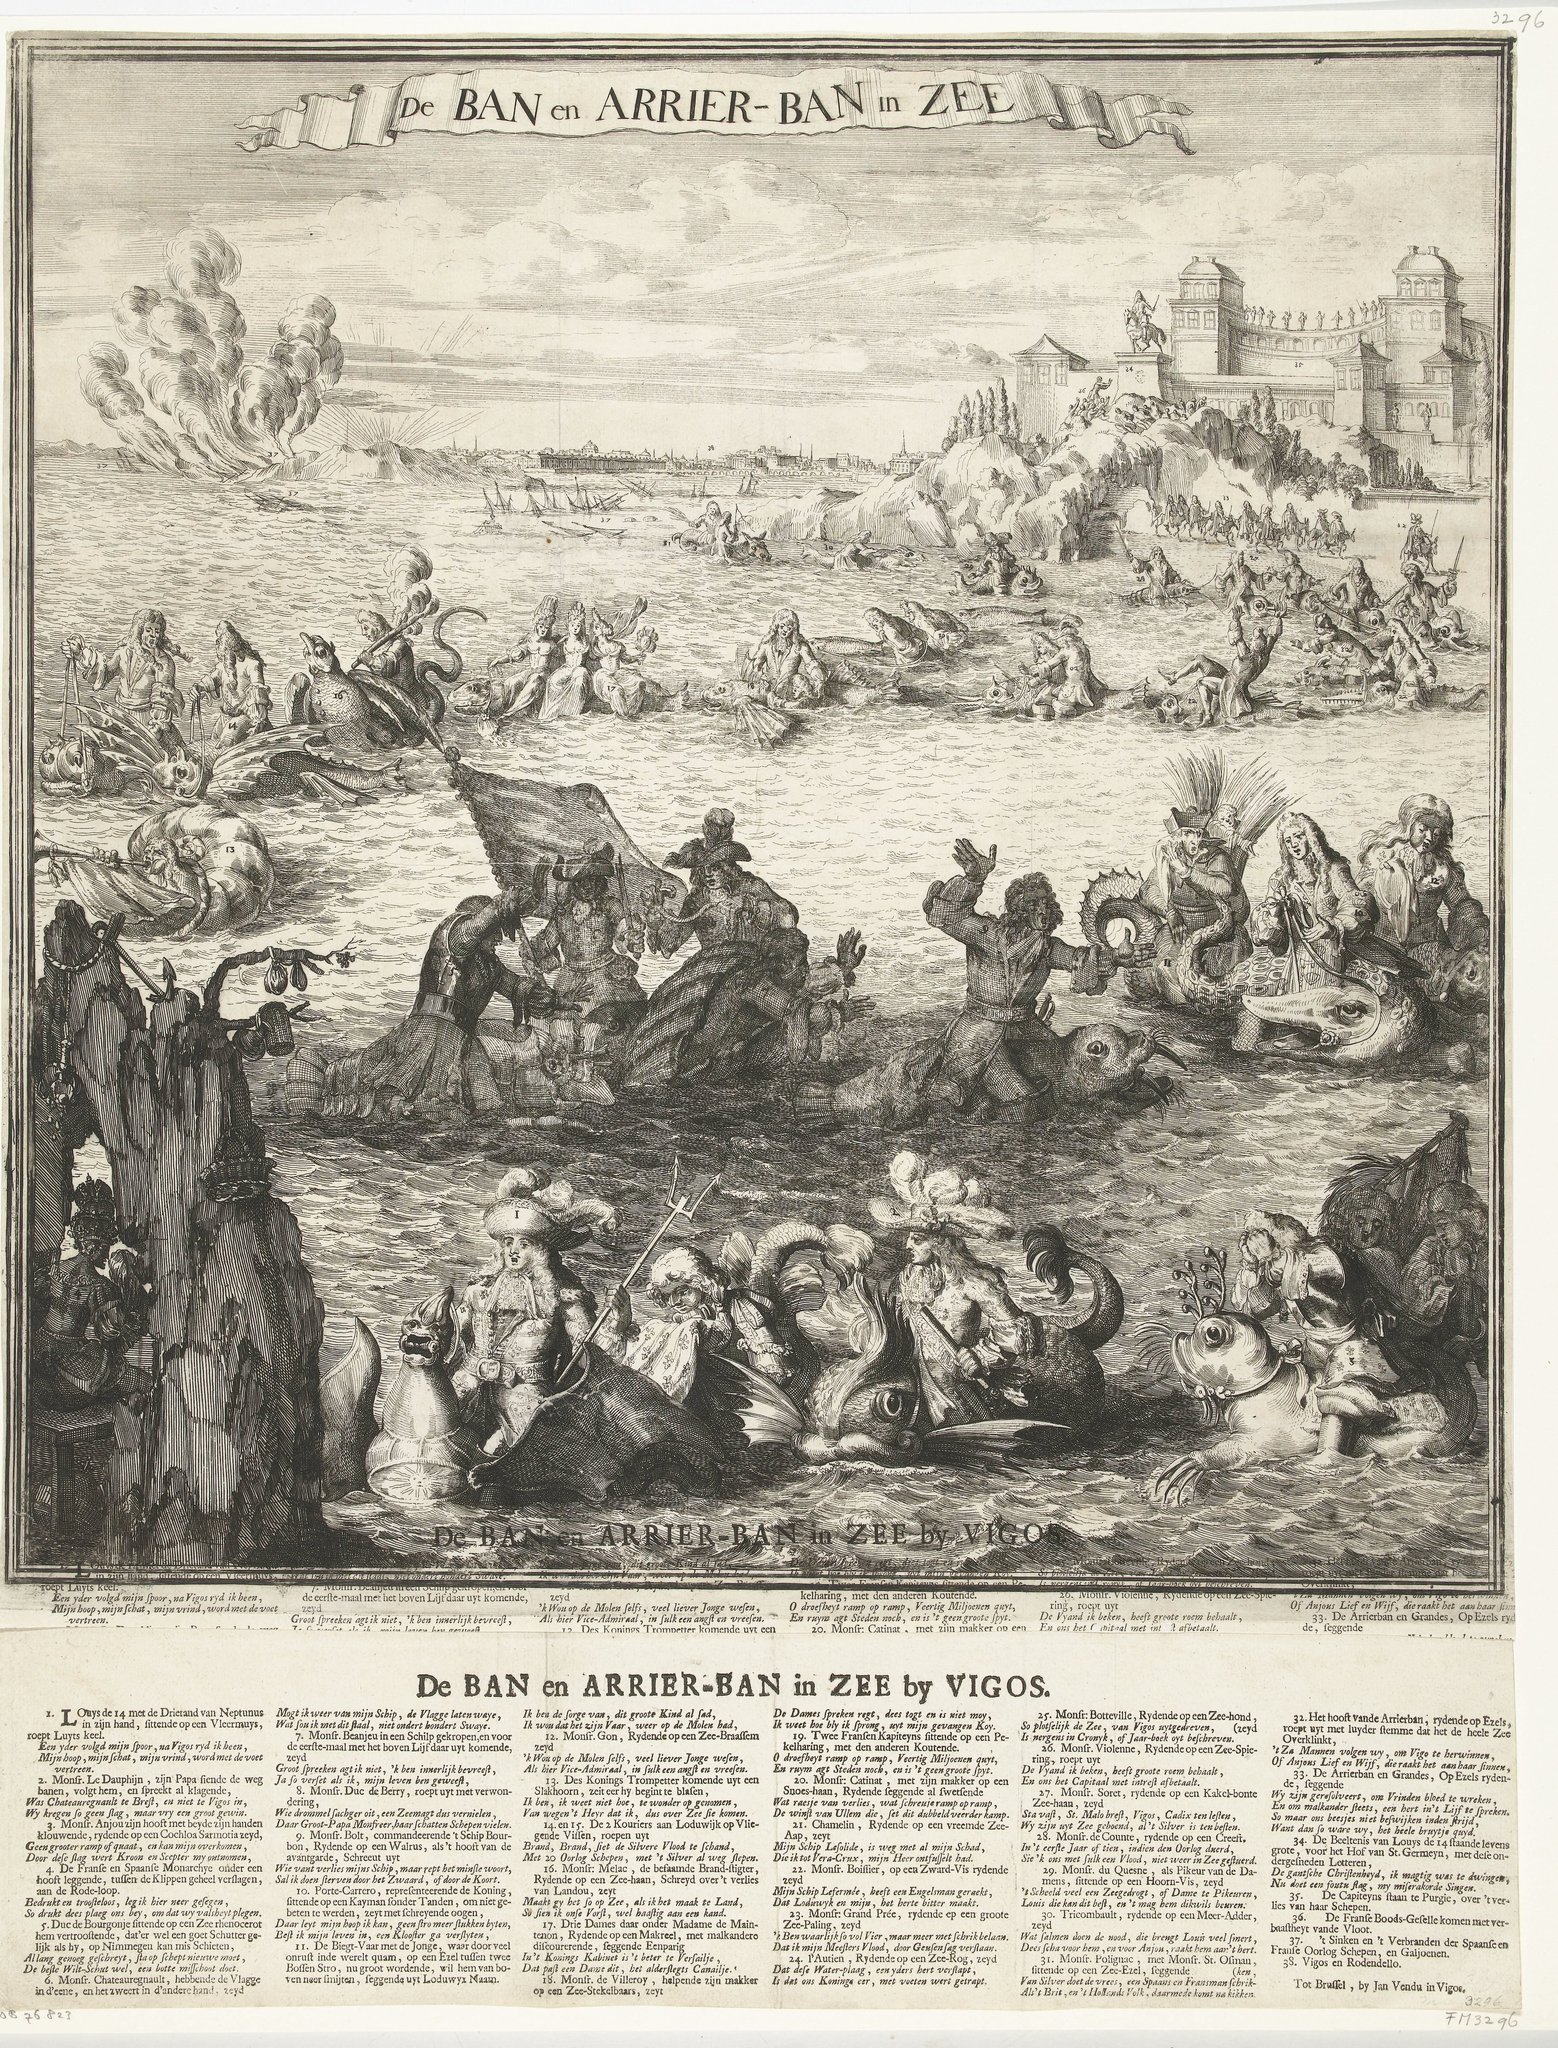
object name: cartoon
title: De Ban en Arrier-Ban in Zee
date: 1702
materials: paper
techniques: etching, letterpress printing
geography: brussels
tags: lodewijk xiv (koning van frankrijk), dauphin van frankrijk lodewijk, political caricatures and satires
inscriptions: inscription: ‘De BAN en ARRIER-BAN in ZEE (by VIGO)’, caption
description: Spotprent op het nemen van de Spaanse zilvervloot op 23 oktober 1702. De zilvervloot lag onder bescherming van een vloot onder bevel van de Franse admiraal Chateaurenault bij Vigo voor de Spaanse kust. In het verschiet de baai van Vigo en de gezonken schepen, in het midden en op de voorgrond een lange ketting van dolfijnen en zeemonsters waarop Lodewijk XIV, de dauphin, admiraal Chateaurenault en andere Fransen en Spanjaarden al jammerend rondzwemmen, een verwijzing naar de barrière waarmee gepoogd werd de haven af te sluiten en de vloot te beschermen. Rechts op de achtergrond een paleis met het ruiterstandbeeld van Lodewijk XIV. Met een los blad met tekst van 6 kolommen waarin een verklaring van de cijfers 1-38 in het Nederlands.